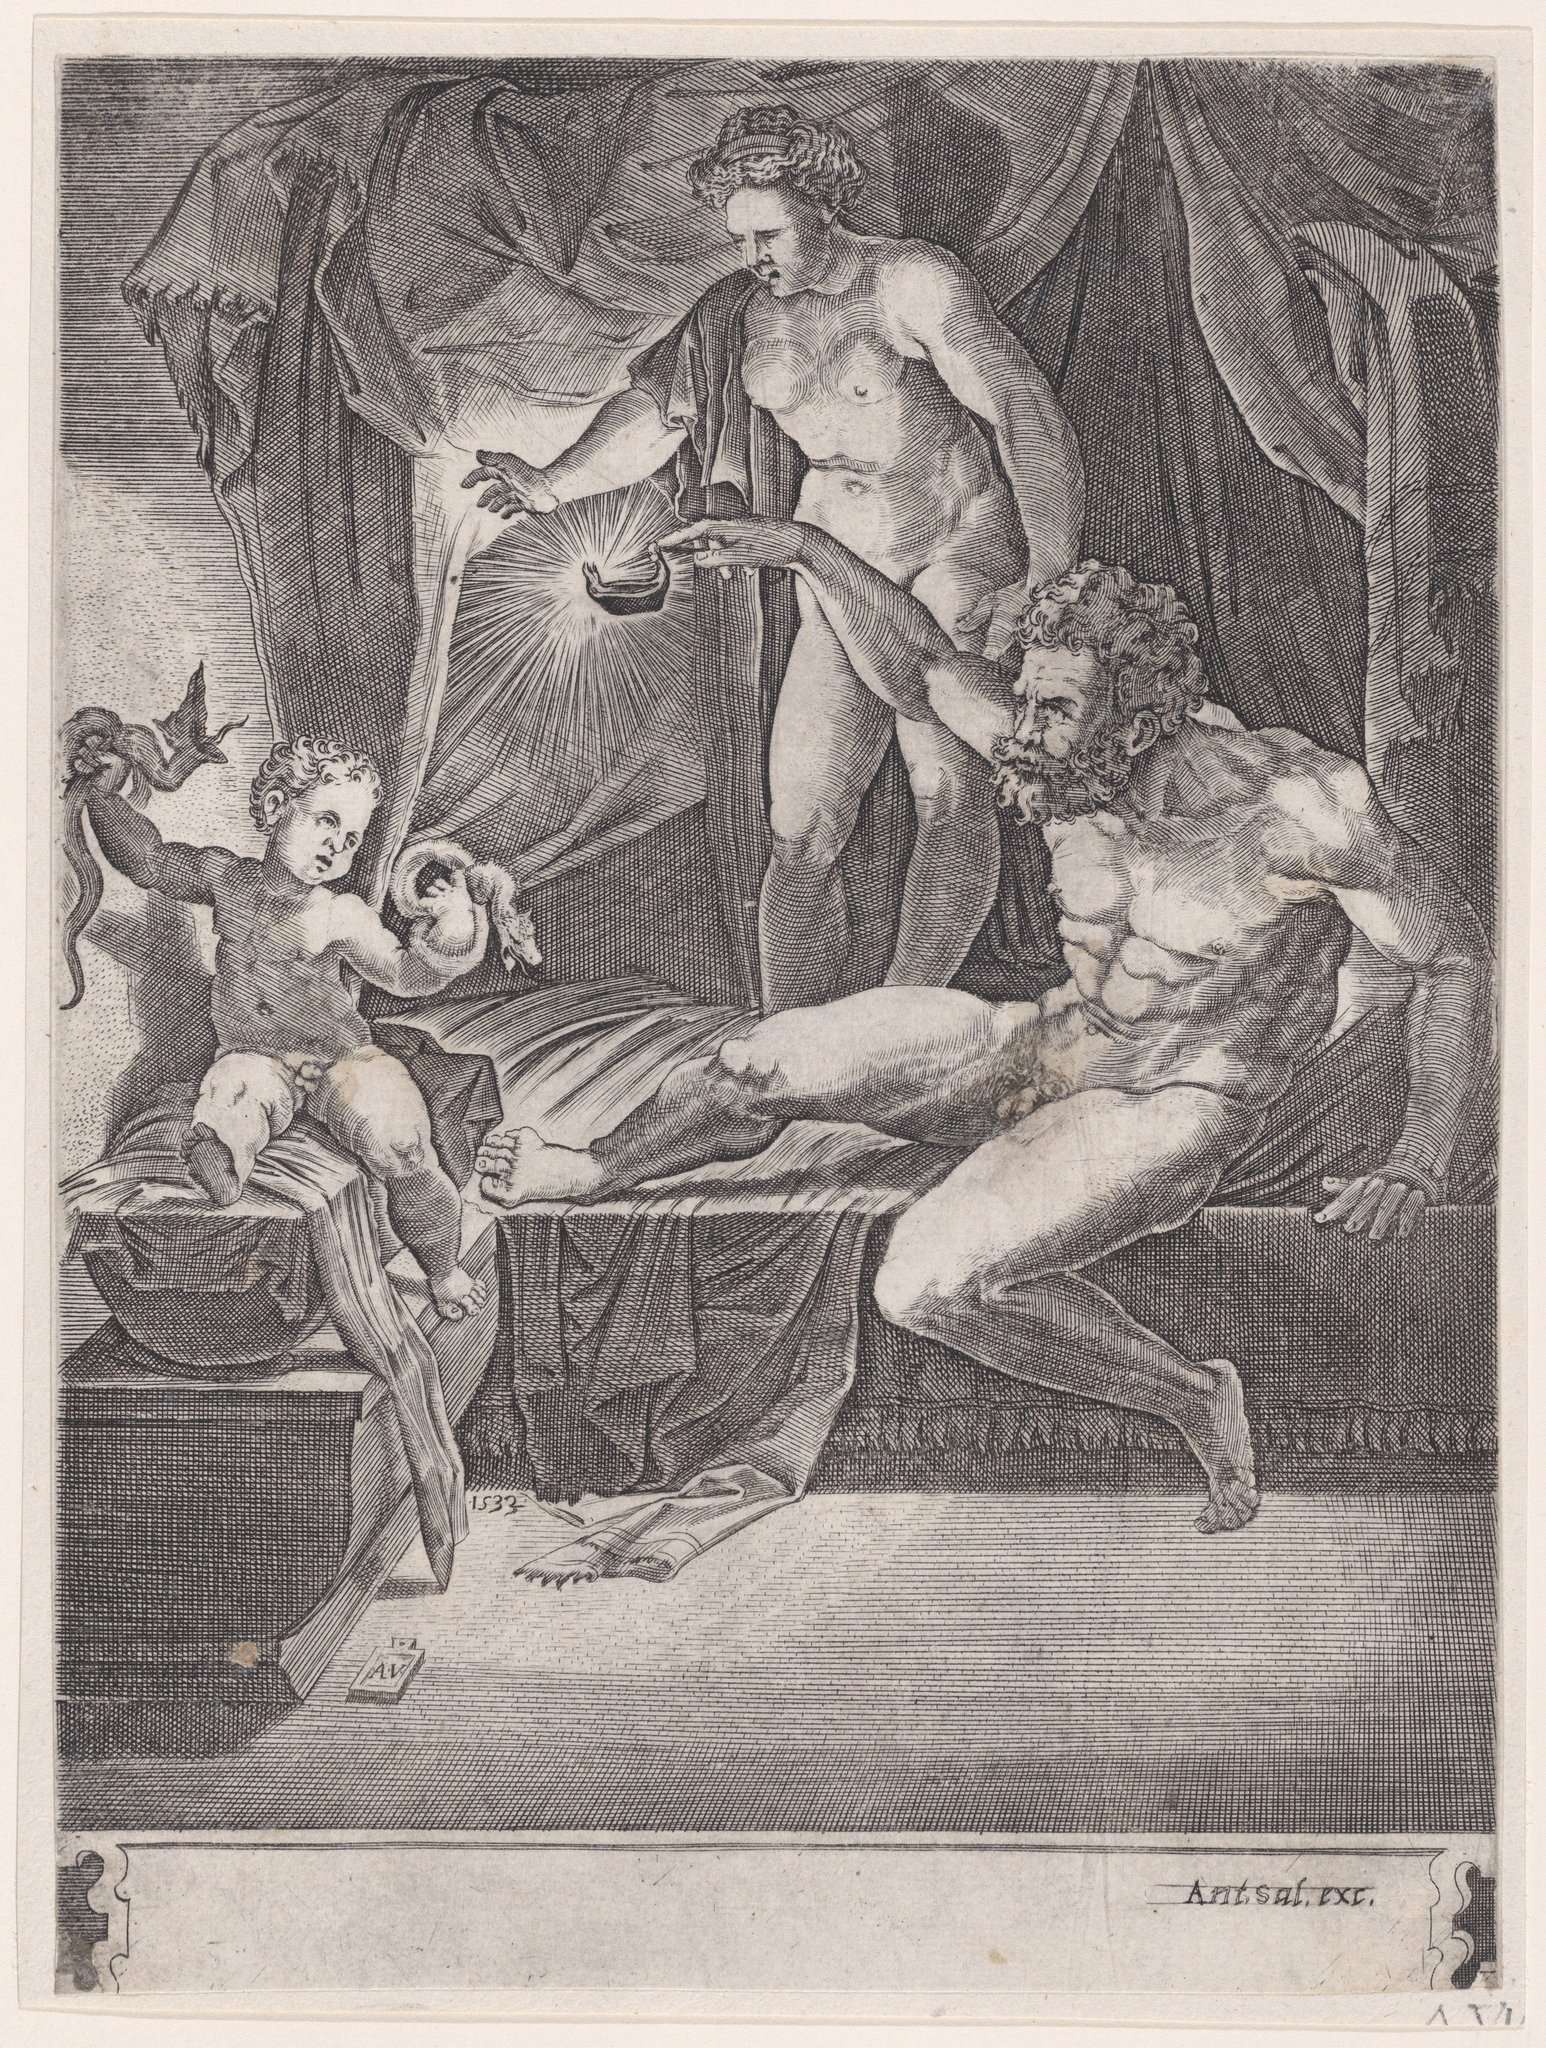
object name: print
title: The Young Hercules in His Cradle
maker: agostino veneziano (agostino dei musi)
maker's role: artist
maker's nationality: italian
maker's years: 1490-1536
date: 1533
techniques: engraving